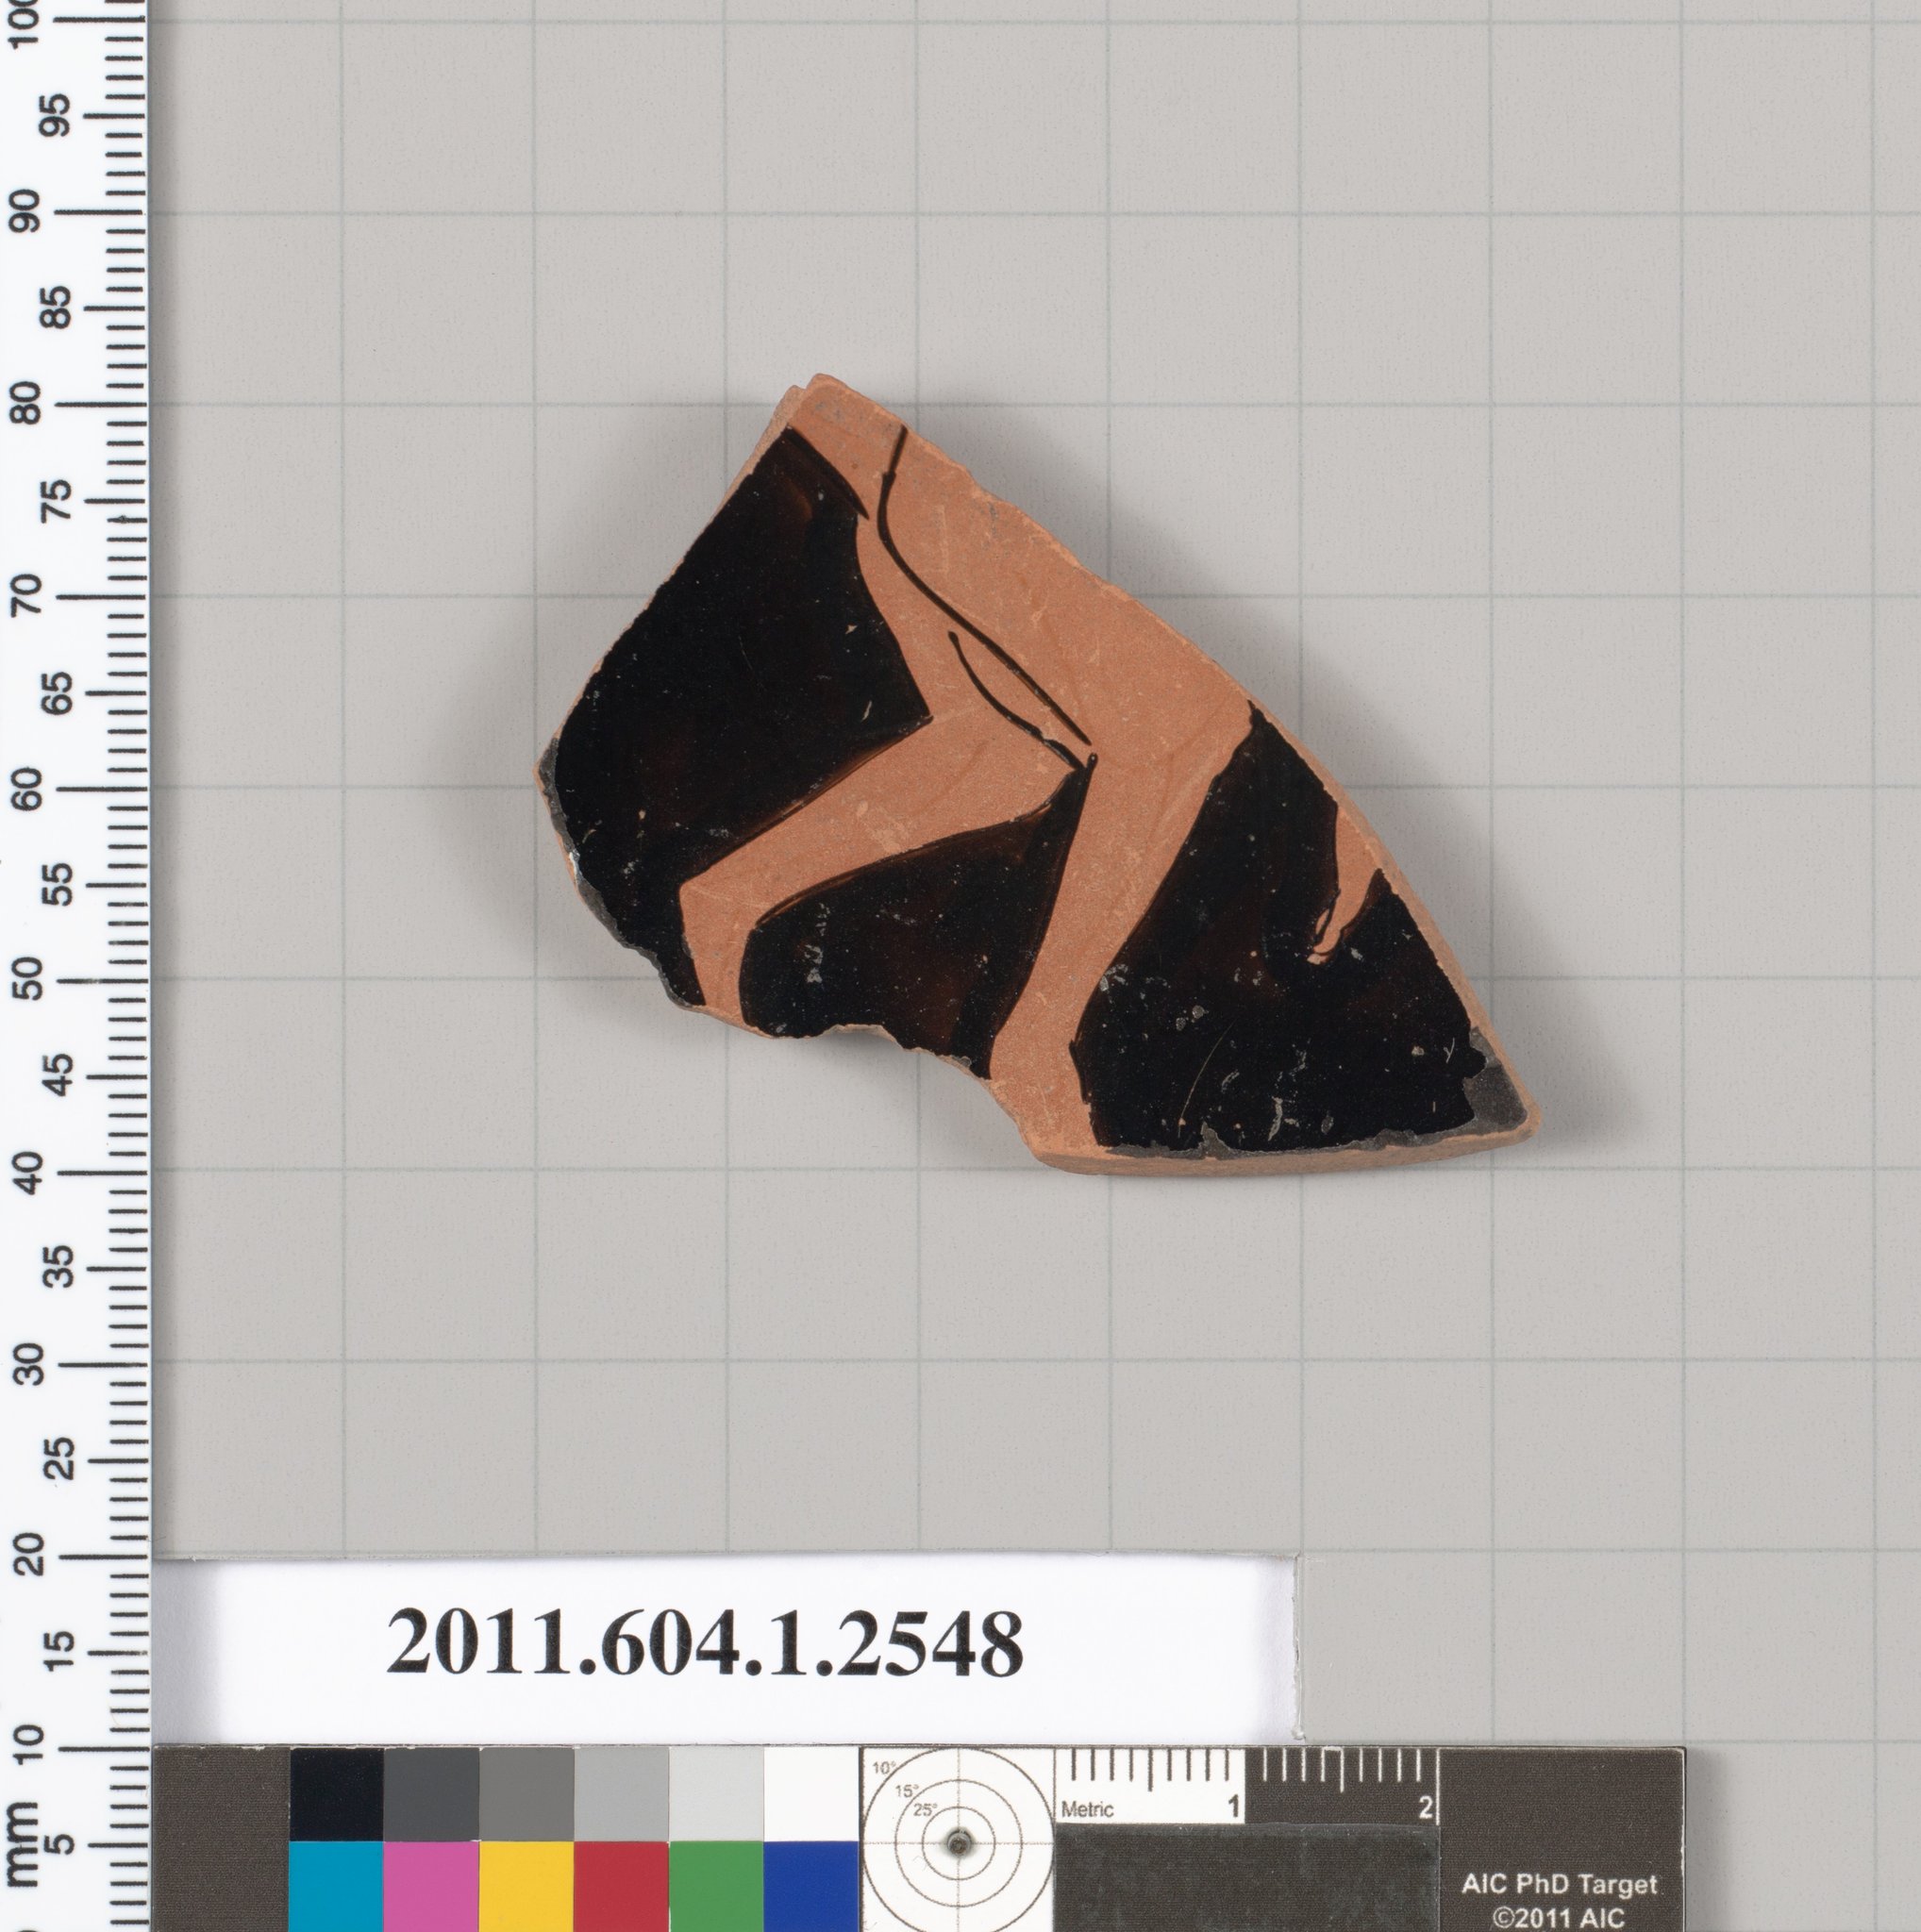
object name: kylix fragment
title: Terracotta fragment of a kylix (drinking cup)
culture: greek, attic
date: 490-480 BCE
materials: terracotta